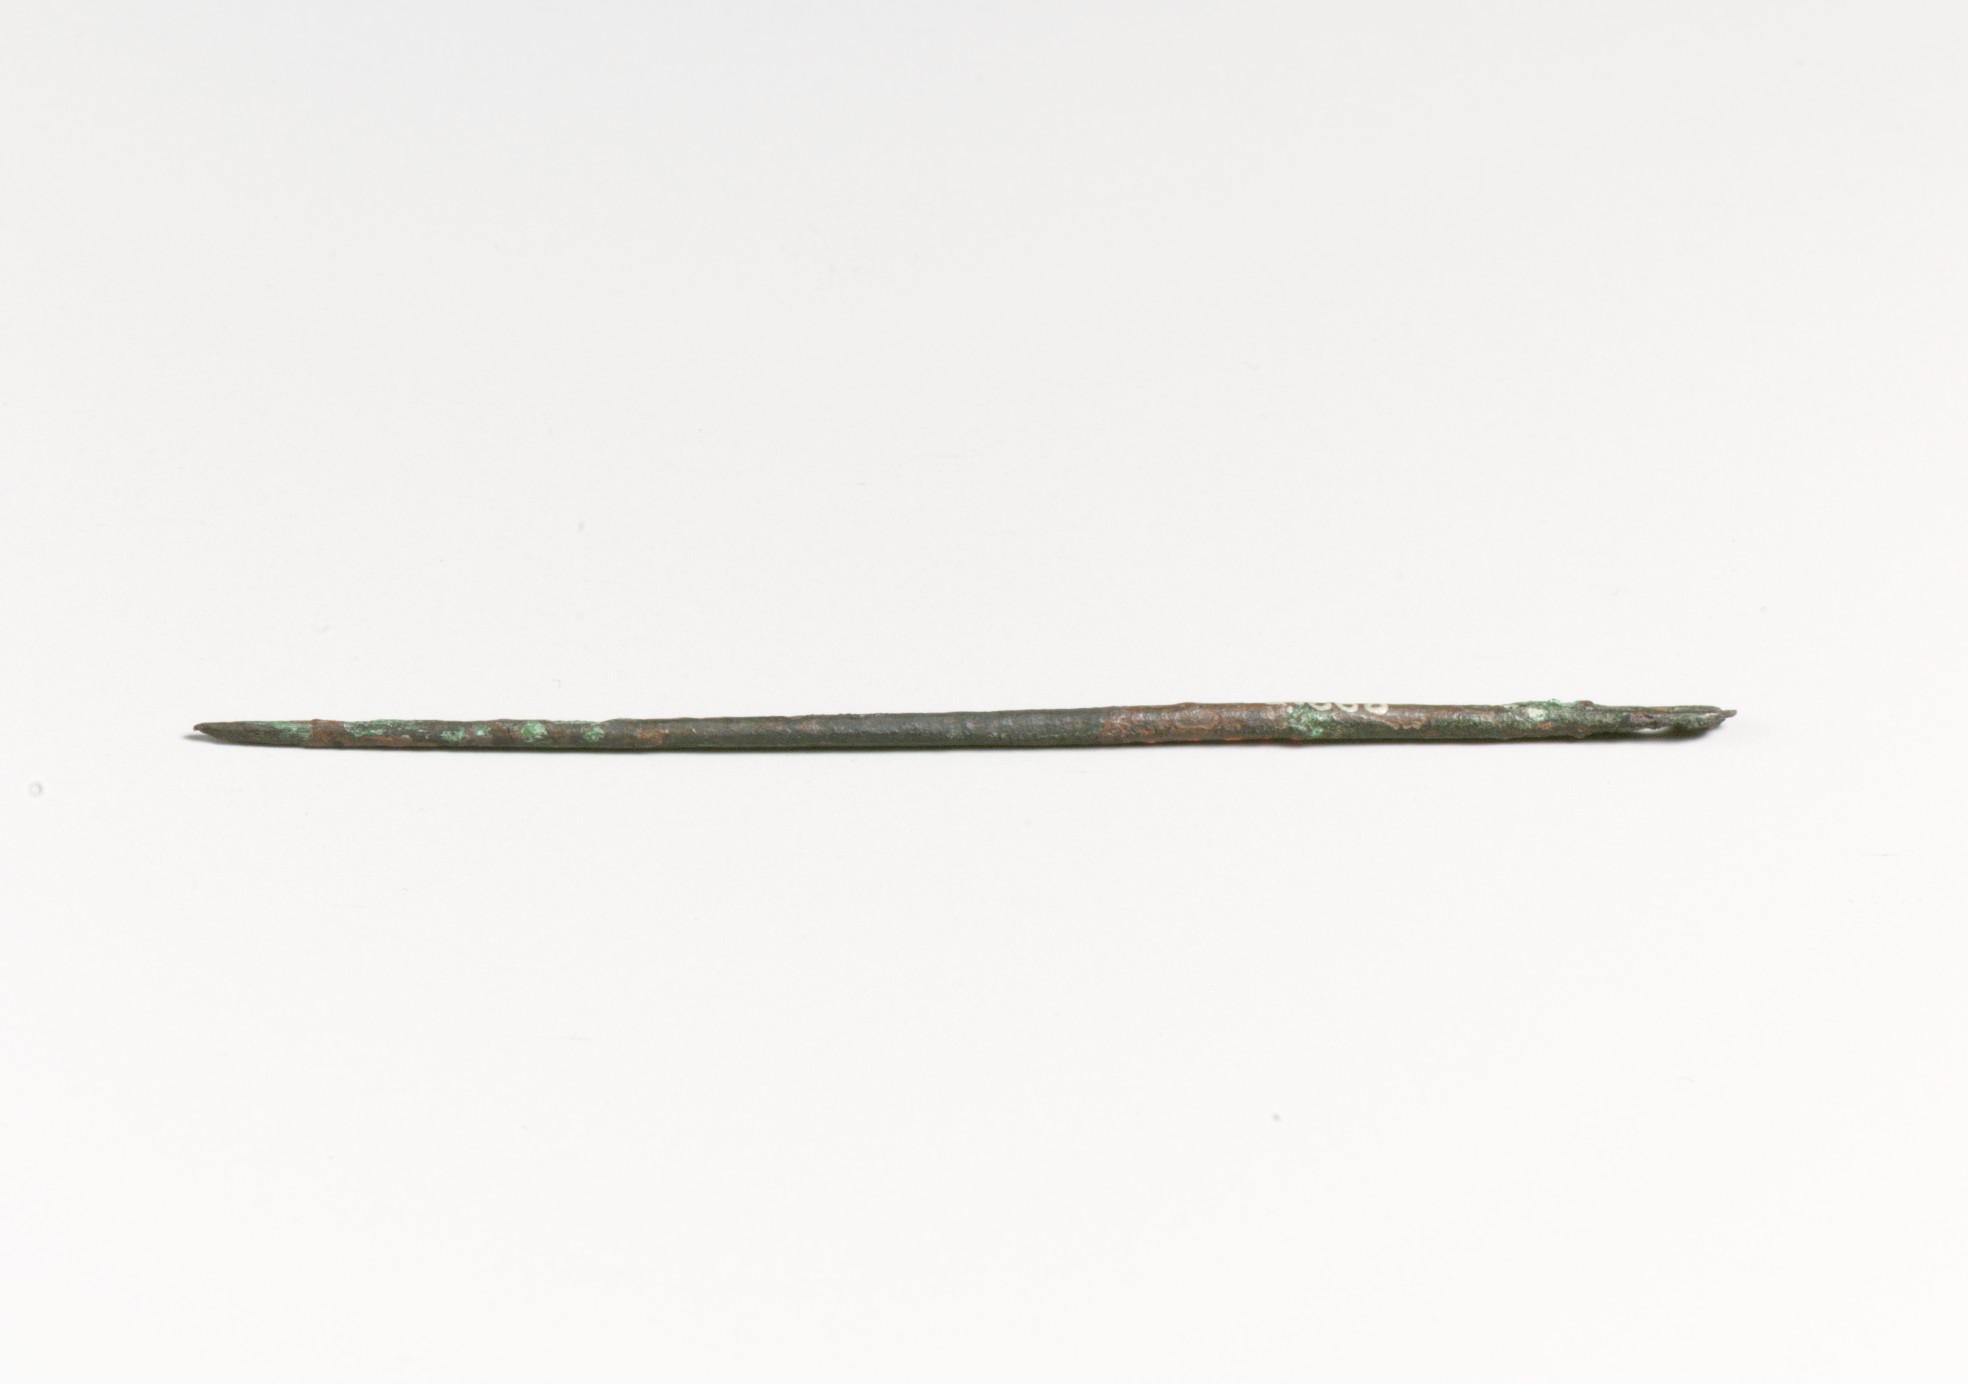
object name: needle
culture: cypriot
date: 3900 BCE-100 CE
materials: bronze